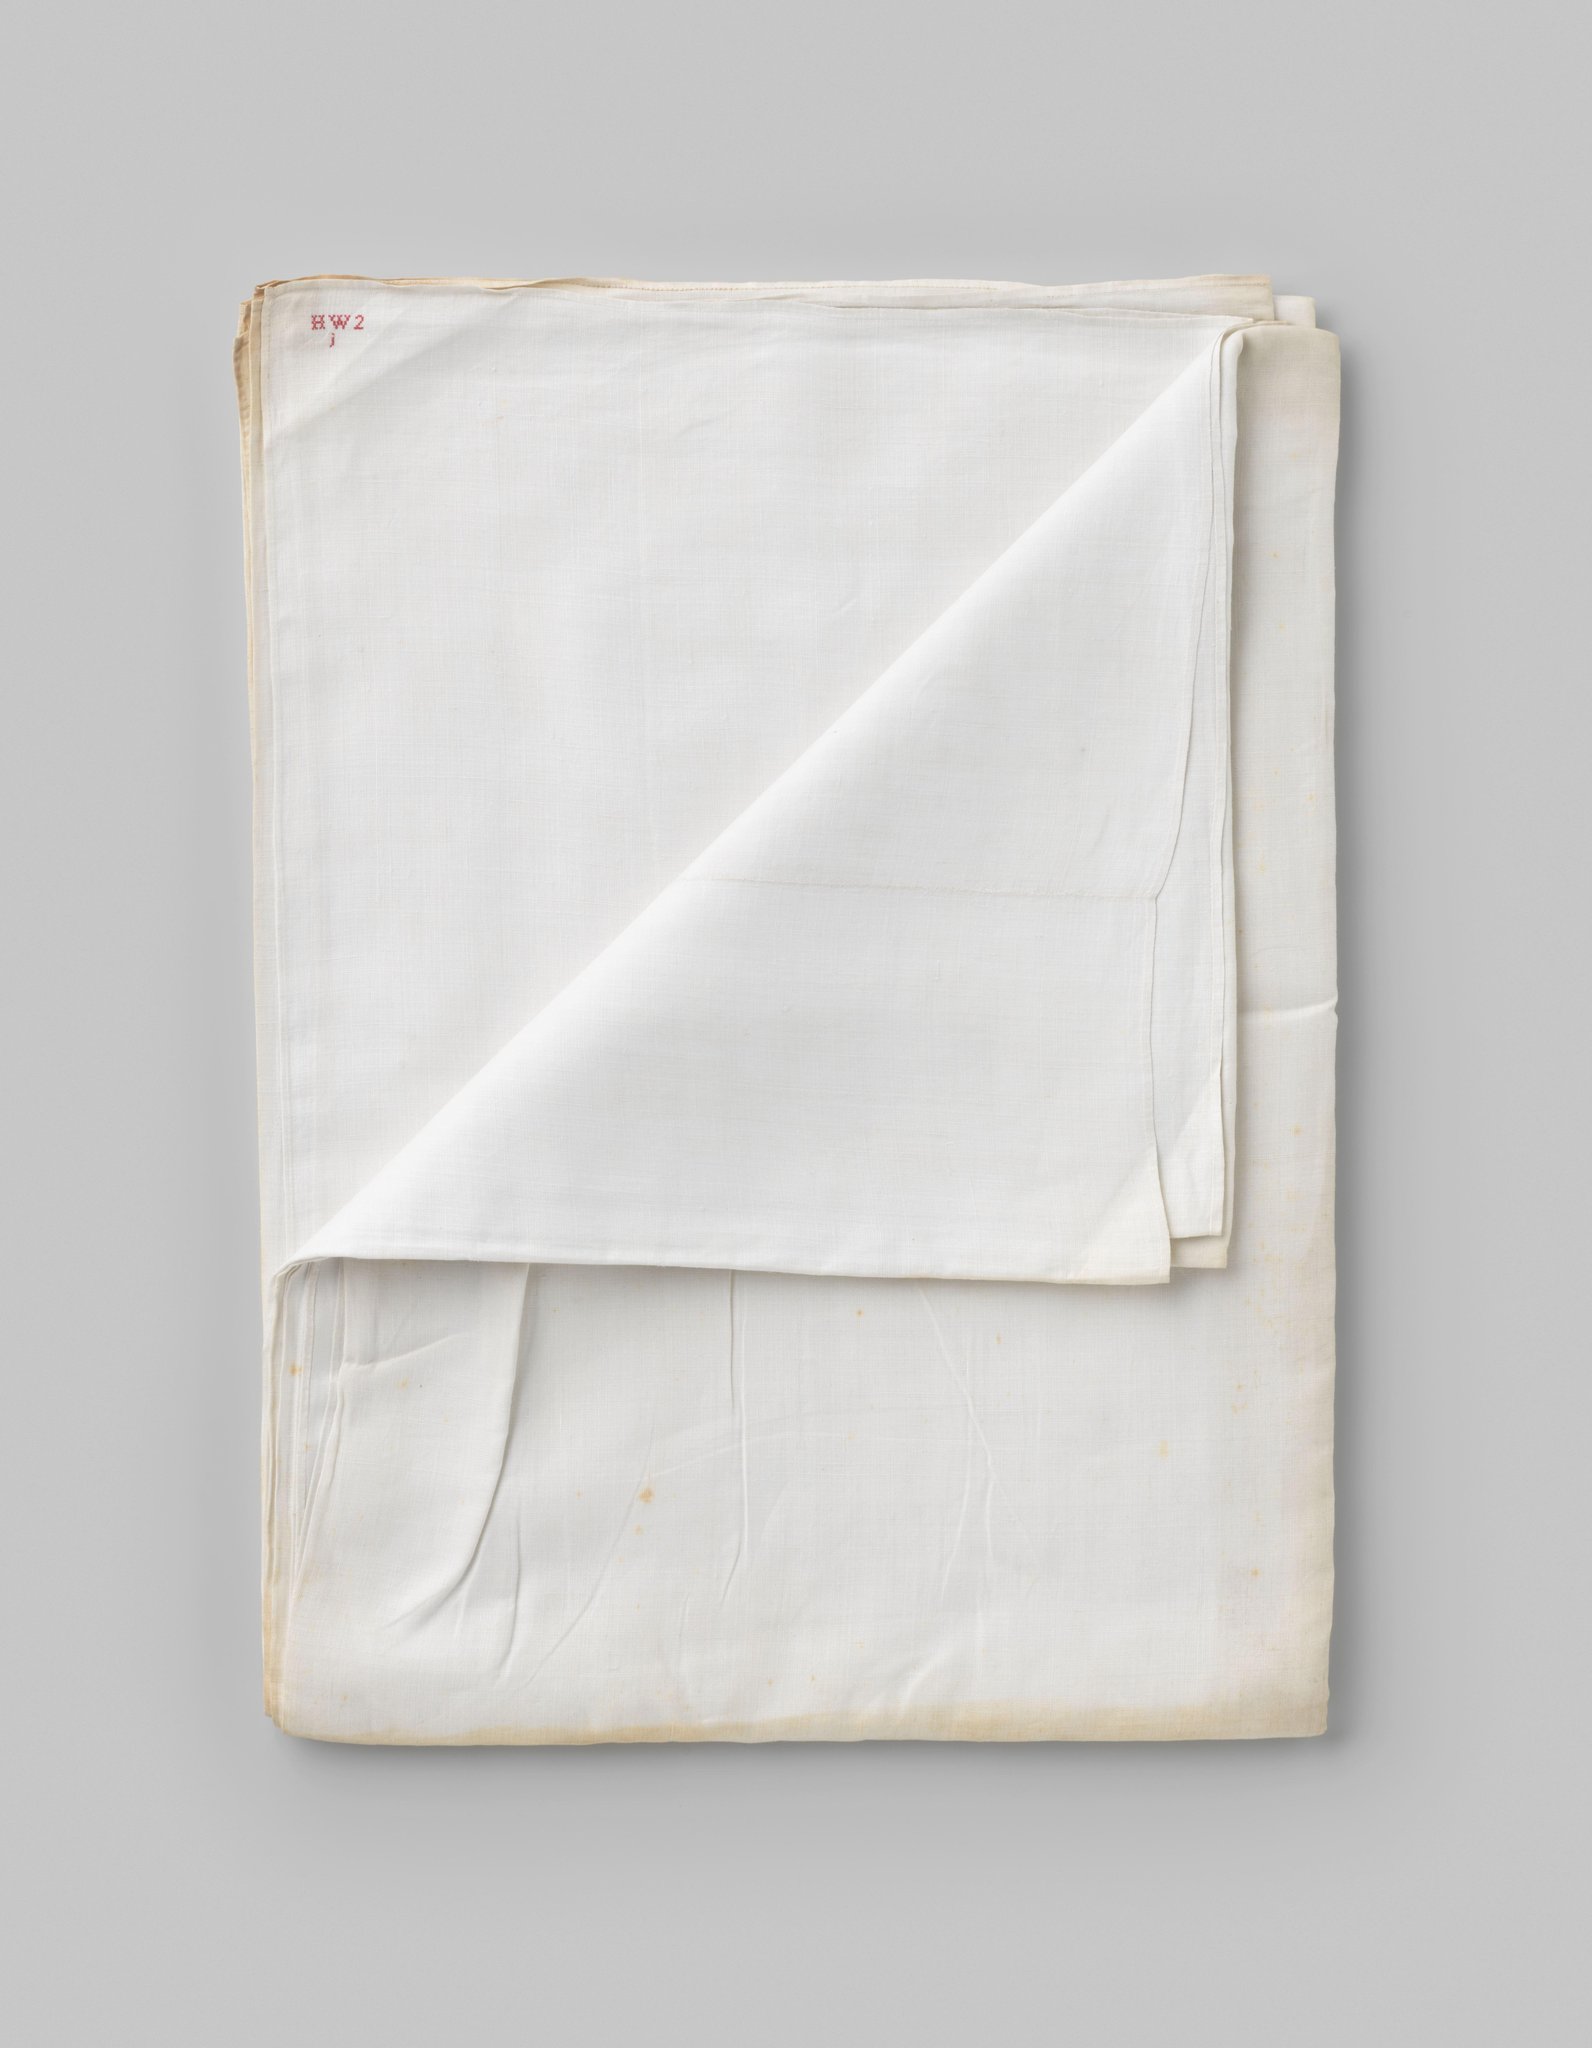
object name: beddenlaken, laken object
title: Laken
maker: Anonymous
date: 1729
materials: linen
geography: northern netherlands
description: Laken van wit linnen, merk kroon WG 8 of IVG 8 en jaartal 1729.